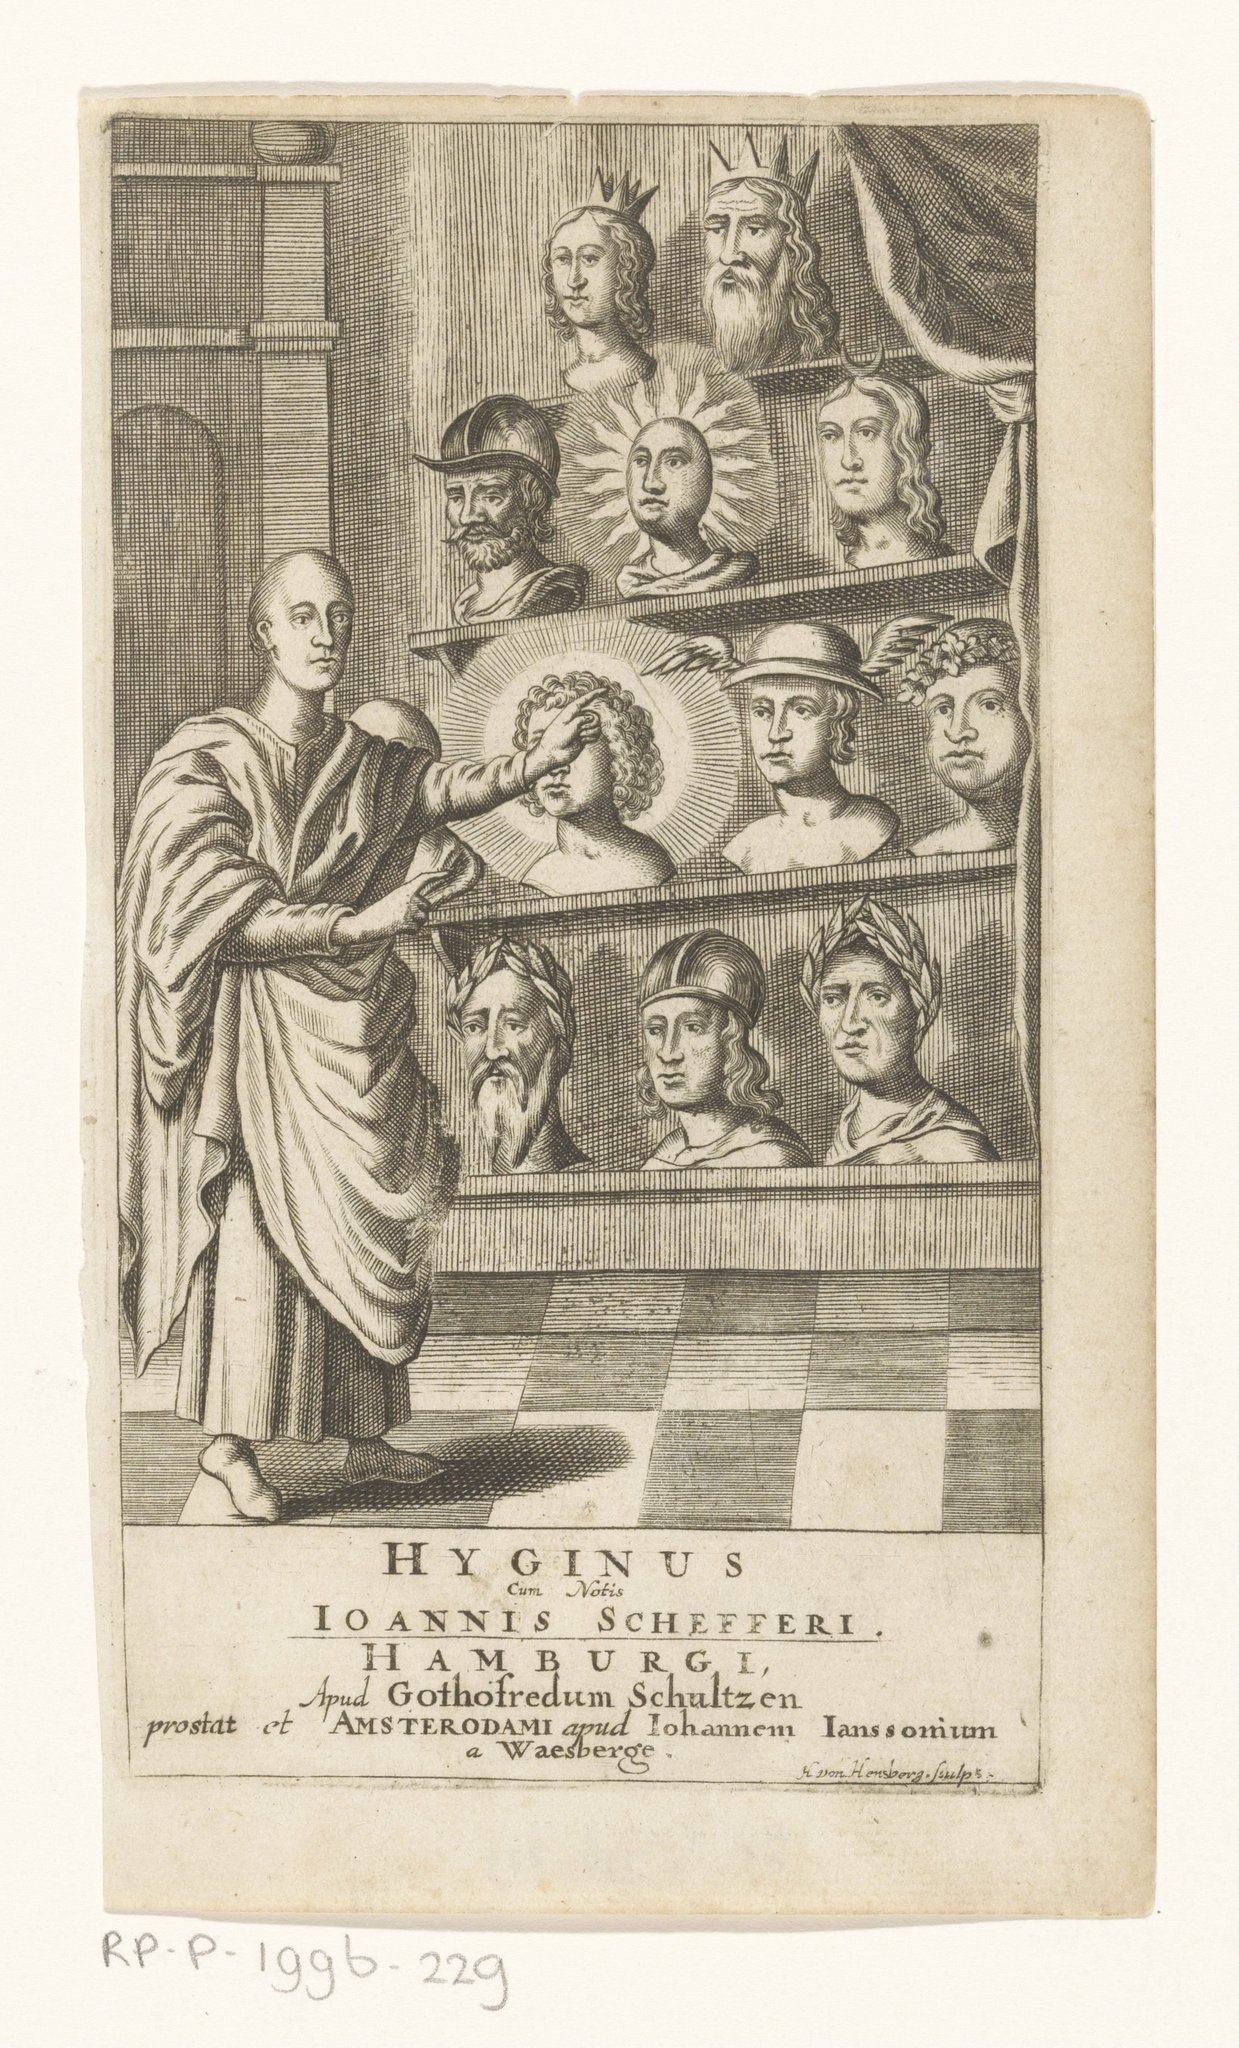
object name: titelblad, titelpagina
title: Hyginus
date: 1674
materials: paper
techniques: engraving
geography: hamburg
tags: rome, writer, poet, author, roman deities, and foreign deities included in the classical pantheon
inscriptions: collector's mark: Lugt 2228, collector's mark: Lugt 2760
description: Een geleerde in toga, vermoedelijk Hyginus, wijst naar een opstelling van gebeeldhouwde koppen van antieke goden.